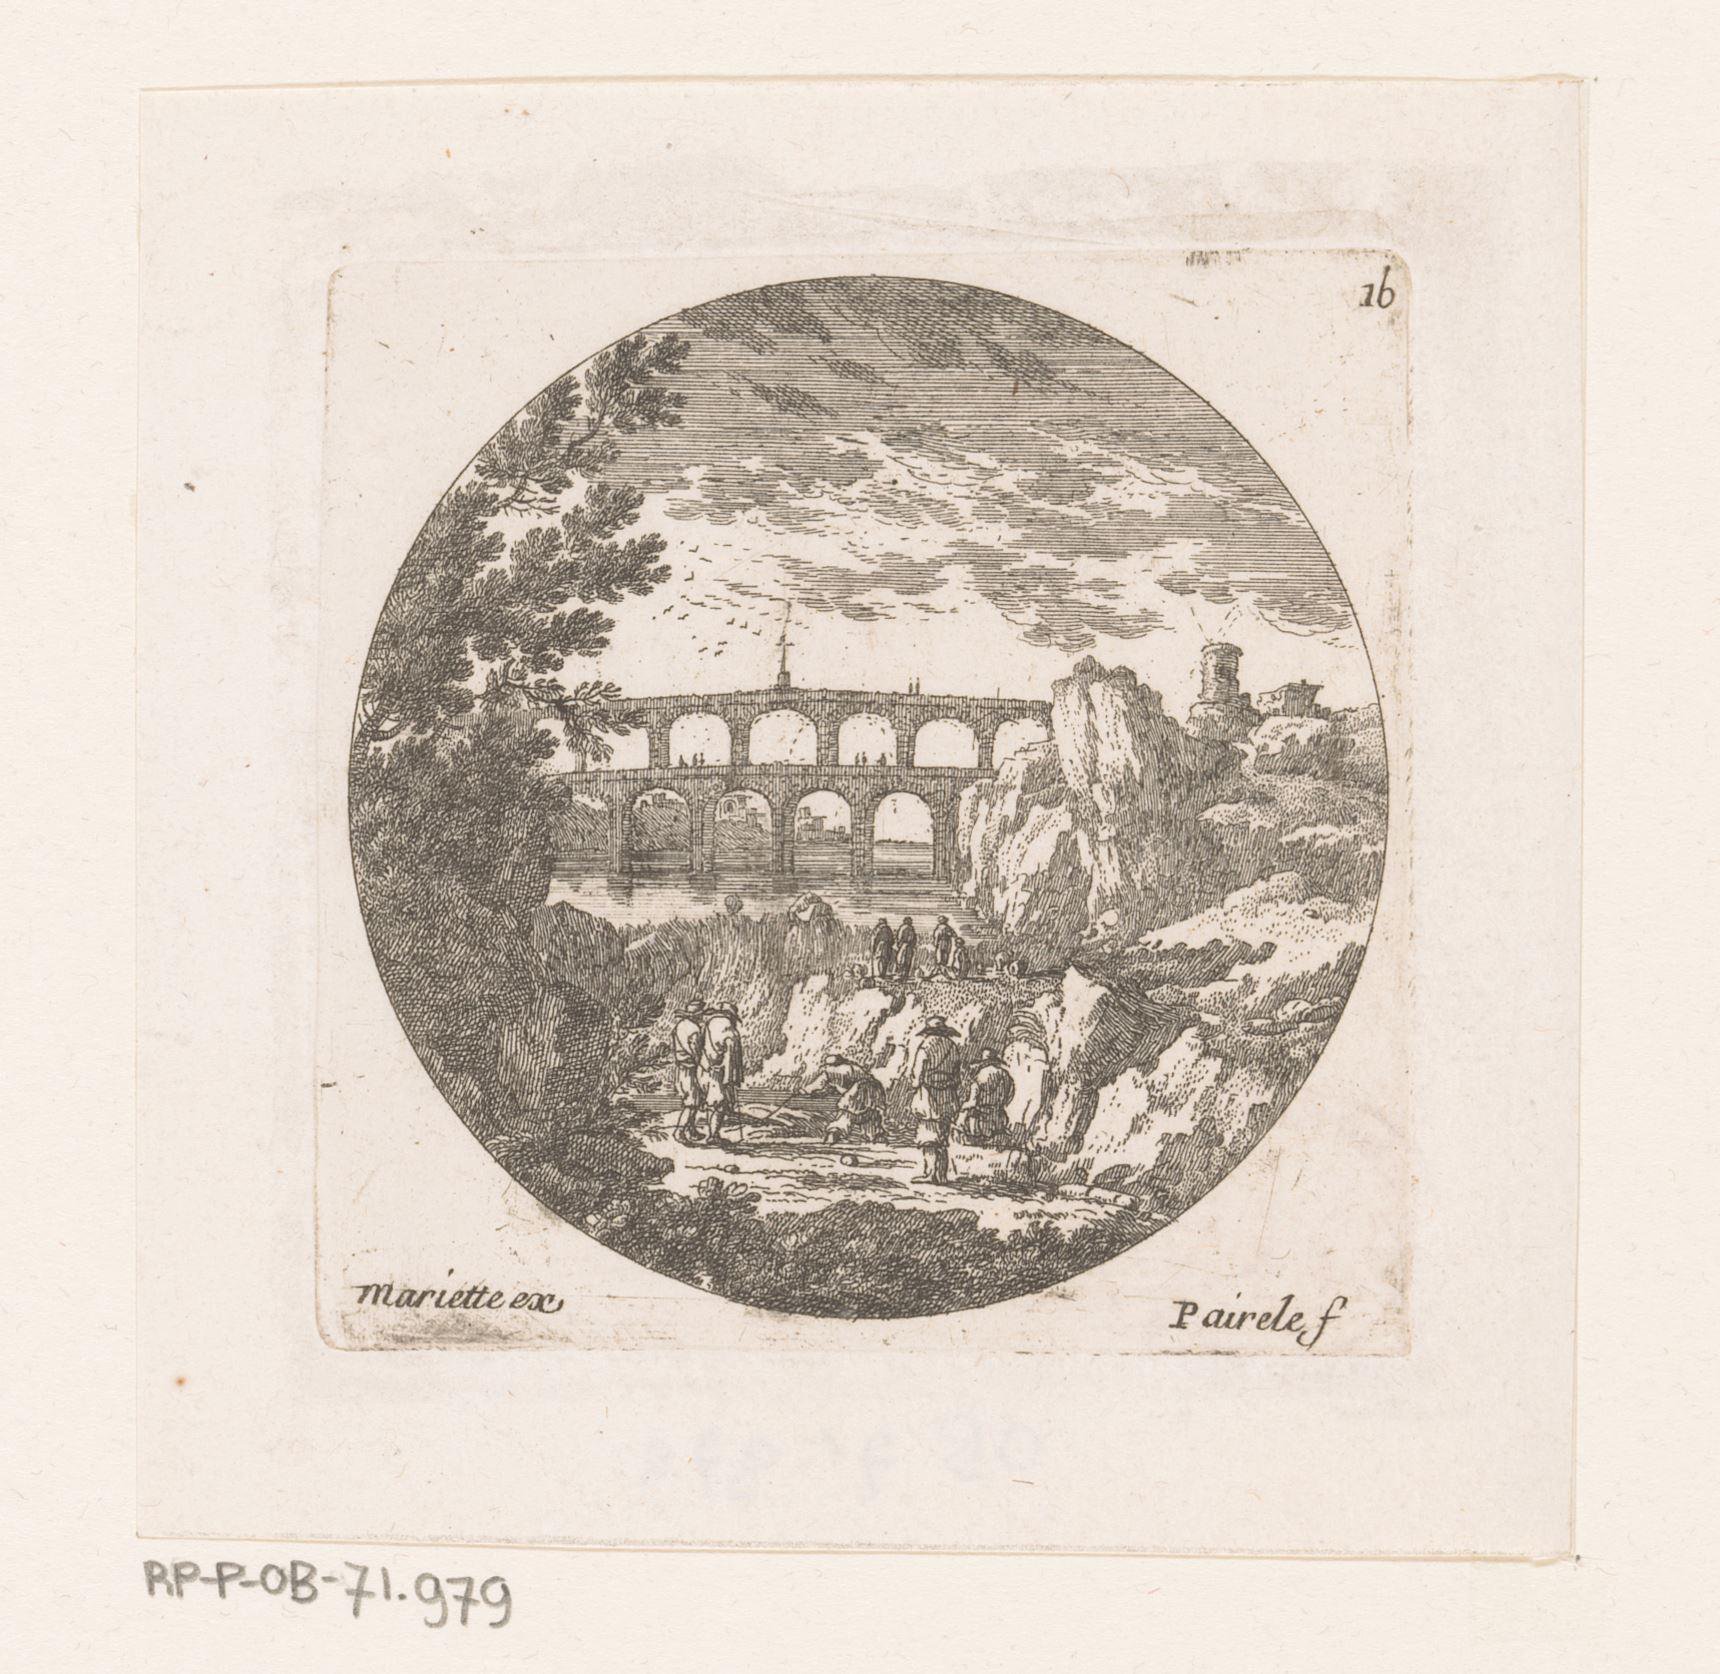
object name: print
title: Landschap met aquaduct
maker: mariette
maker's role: publisher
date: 1613-1695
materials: paper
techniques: etching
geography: paris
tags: landscape with bridge, viaduct or aqueduct (+ city(-scape) with figures, staffage)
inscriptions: collector's mark: Lugt 240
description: Prenten met het signatuur 'Perelle' kunnen zowel door vader Gabriel als door zonen Nicolas en Adam gemaakt zijn.